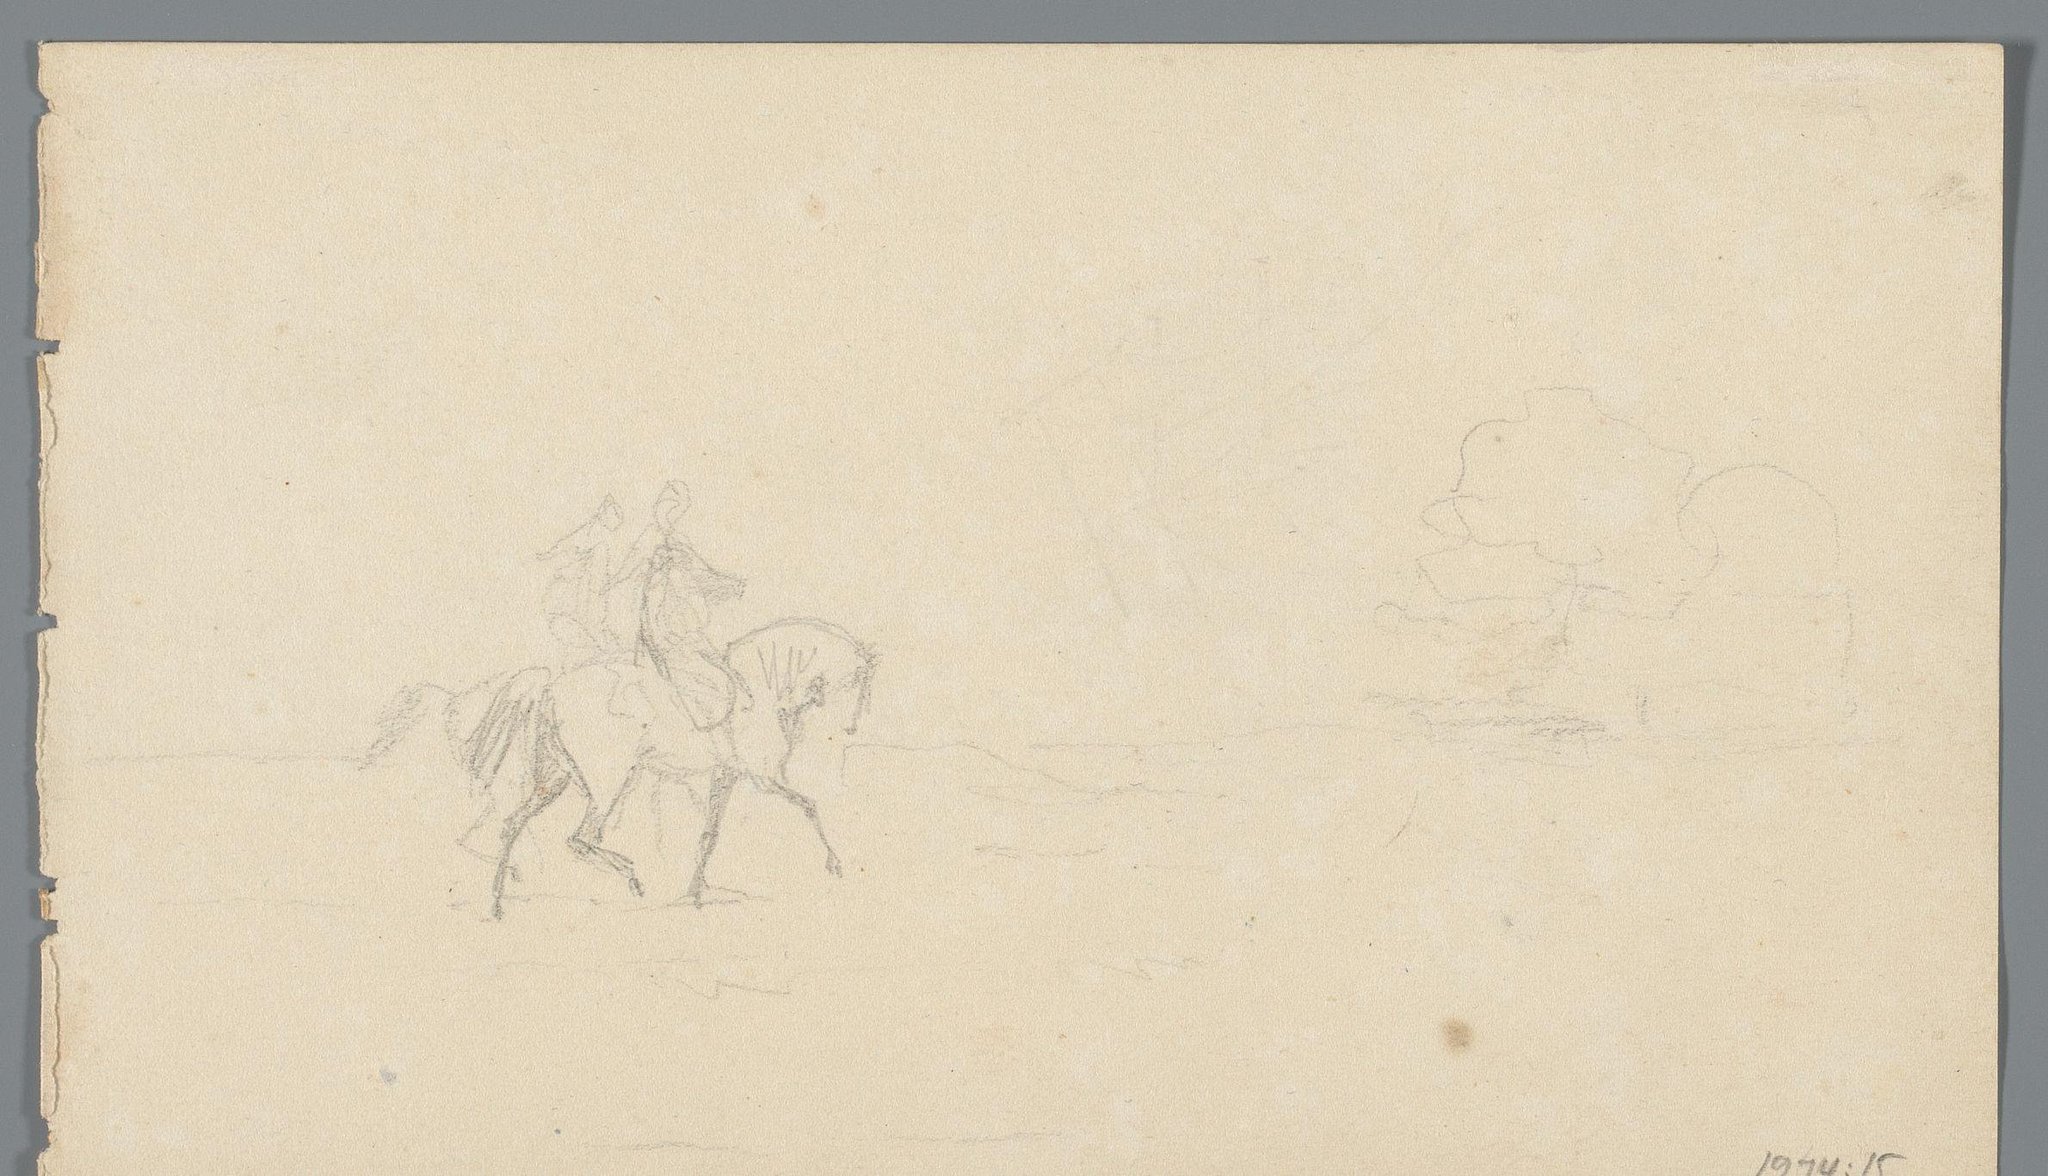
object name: sketchbook leaf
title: Landschap met twee ruiters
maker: willem de famars testas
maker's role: draughtsman, painter, print maker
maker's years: 1834-1896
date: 1858-1859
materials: paper, pencil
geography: egypt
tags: riding a horse, ass, or mule; rider, horseman, desert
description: Onderdeel van 20 losse bladen met tekeningen gemaakt tijdens Famars Testas zijn Egyptische reis van 1858, met voornamelijk figuren en dorpsgezichten met notities.